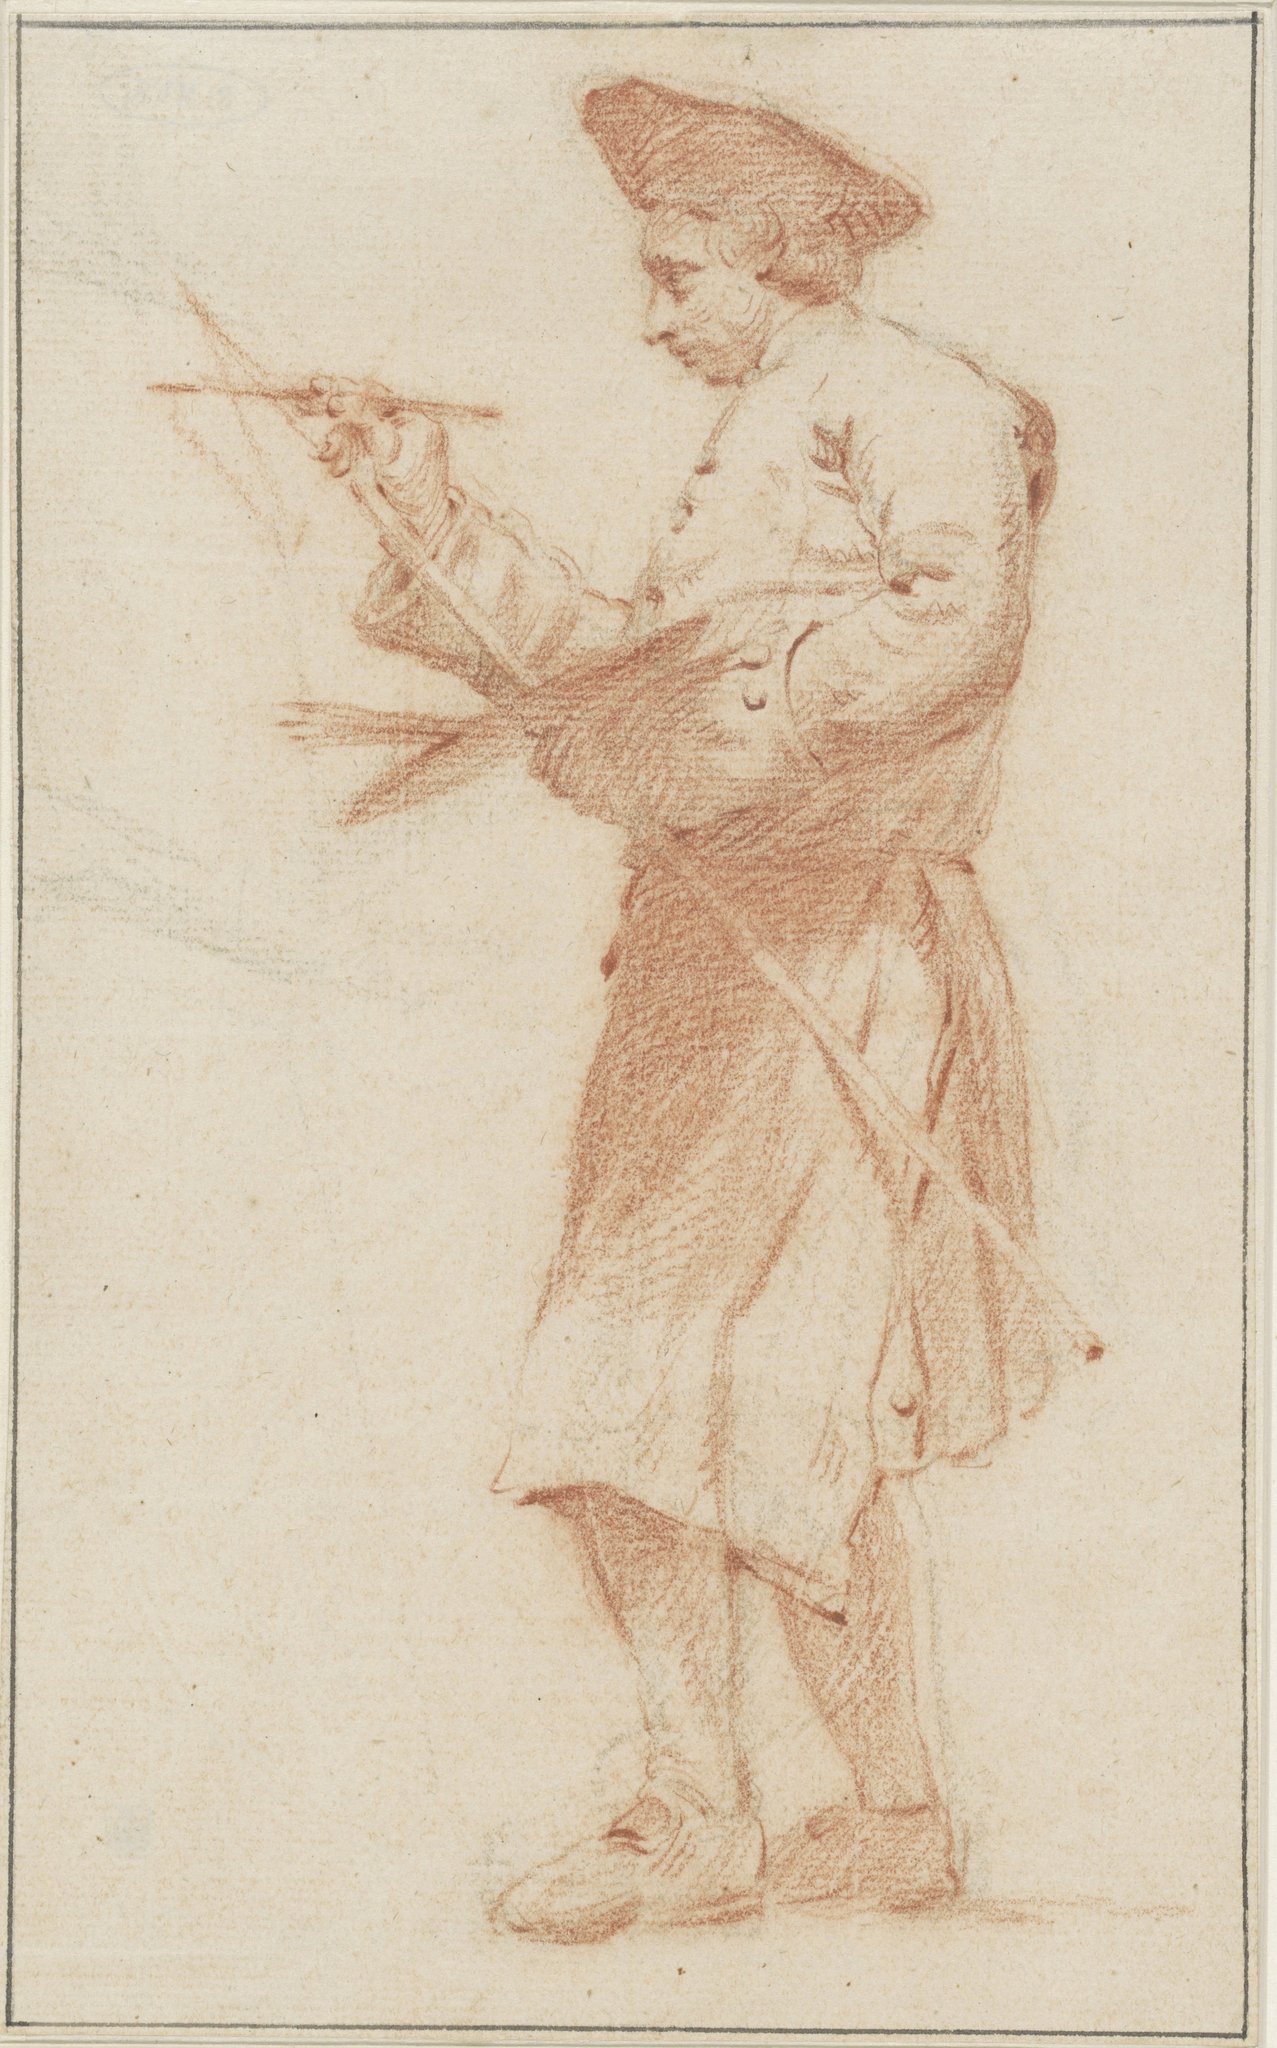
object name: drawing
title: Zelfportret van Leendert Overbeek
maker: leendert overbeek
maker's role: draughtsman, painter, print maker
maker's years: 1752-1815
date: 1762-1815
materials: chalk, paper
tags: haarlem, painter, print maker, draughtsman, leendert overbeek, historical persons, portrait, self-portrait of painter, painter at work, in his studio, portrait, self-portrait of artist